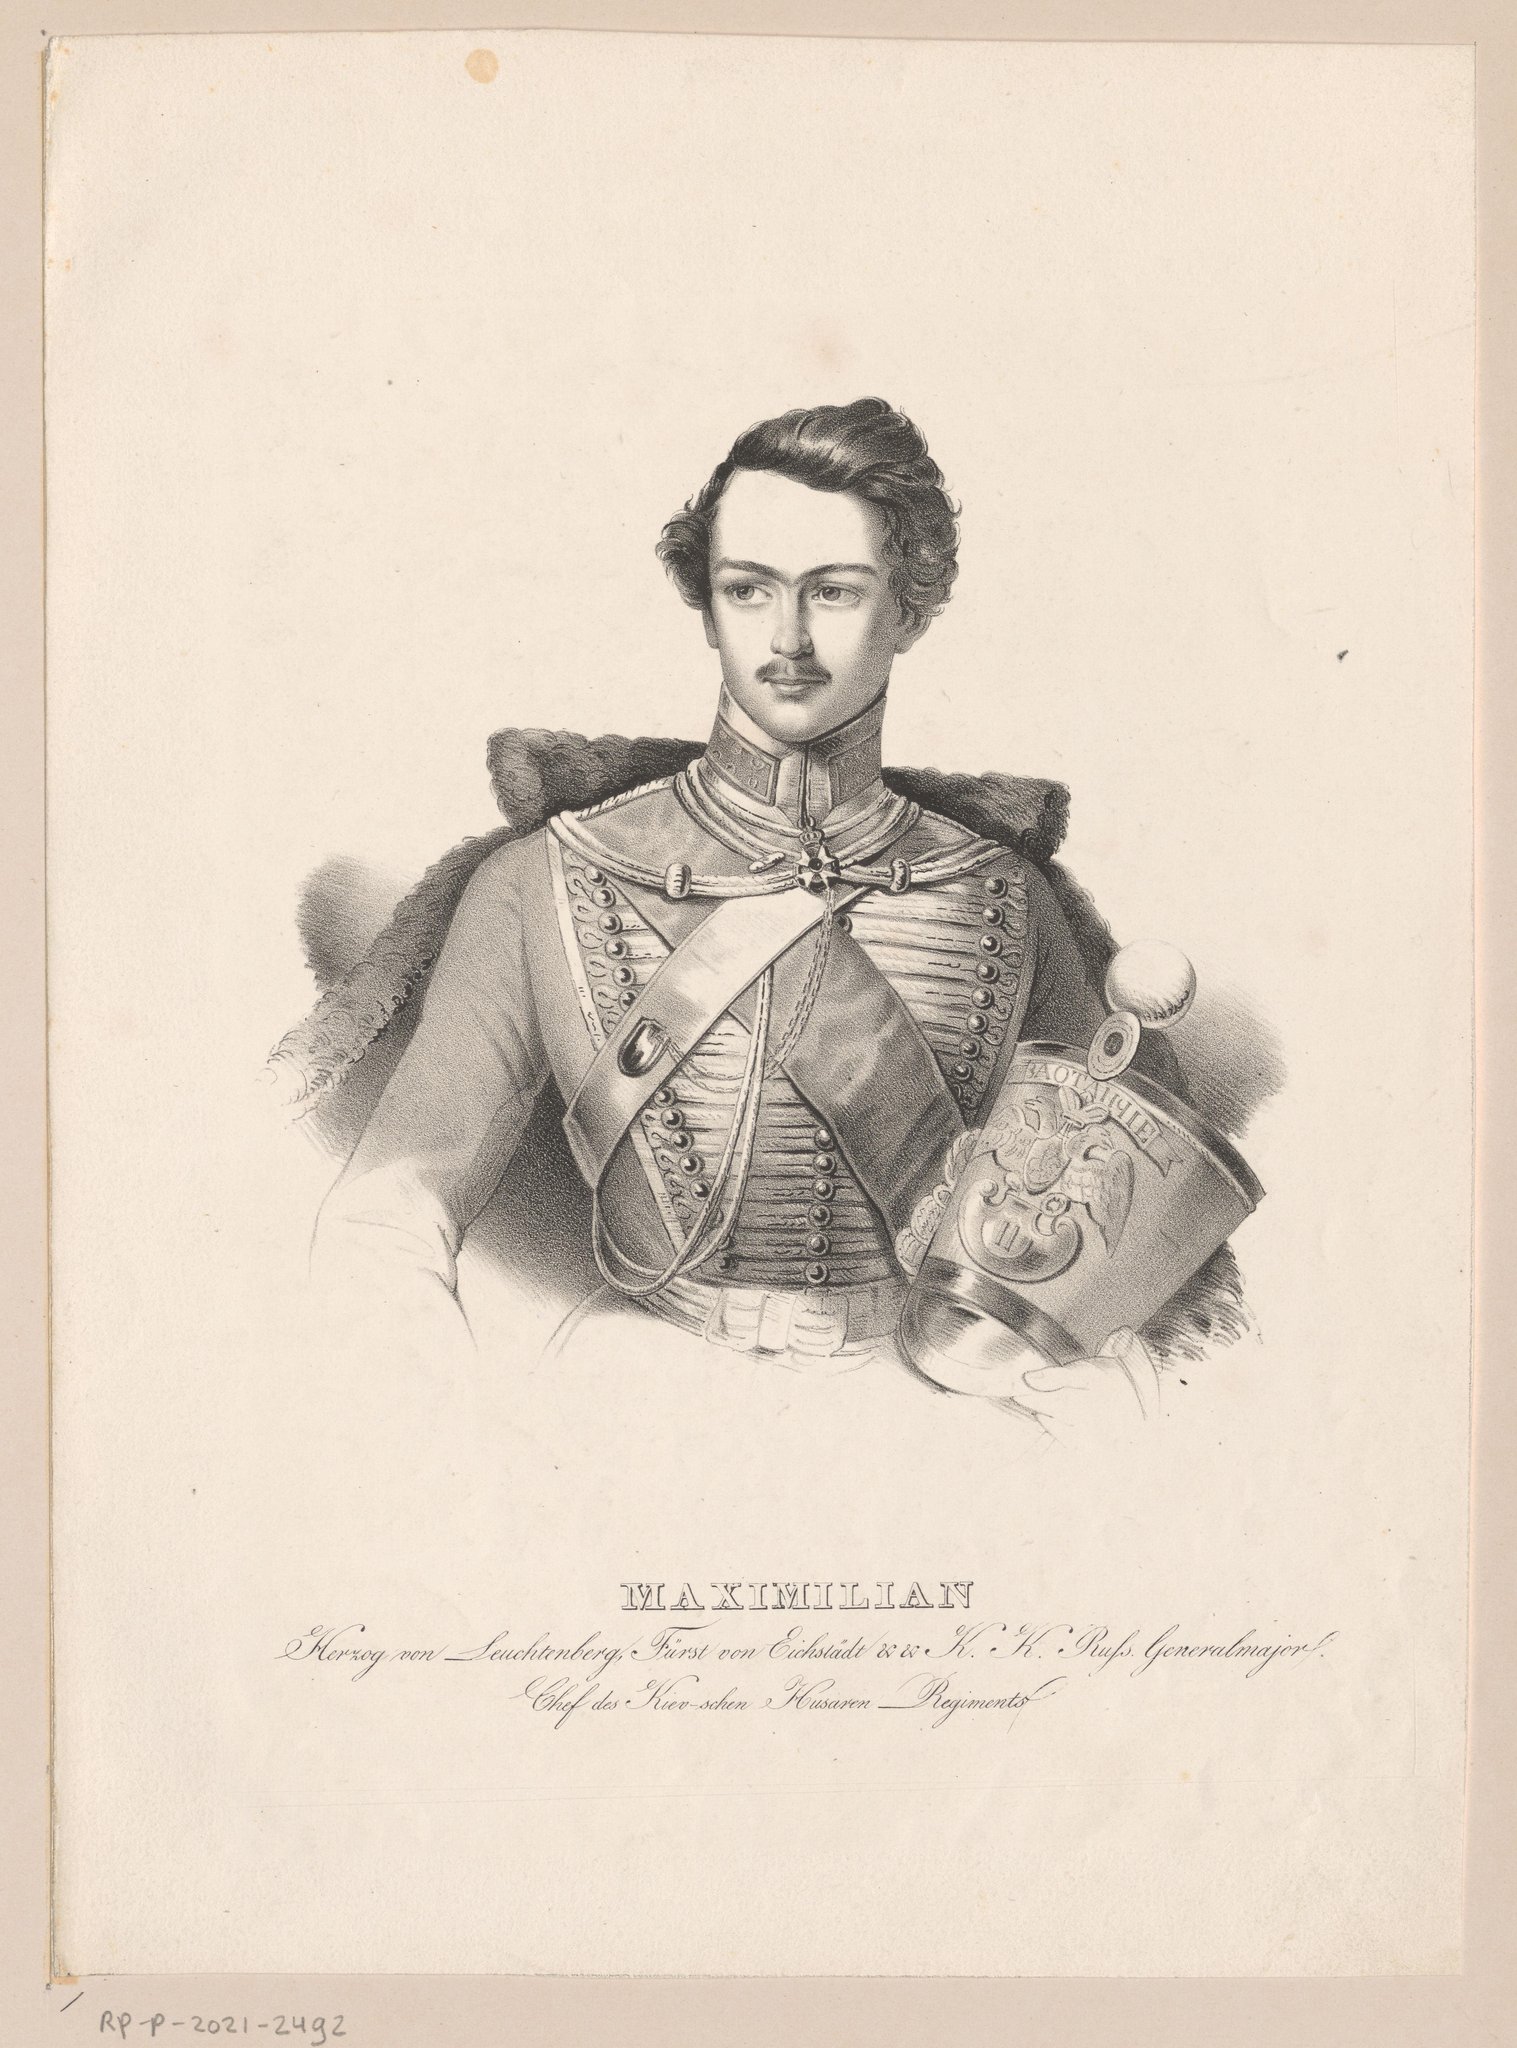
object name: print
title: Portret van Maximiliaan van Leuchtenberg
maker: Anonymous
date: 1837-1850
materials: paper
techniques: lithograph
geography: germany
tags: historical persons, (military) uniforms